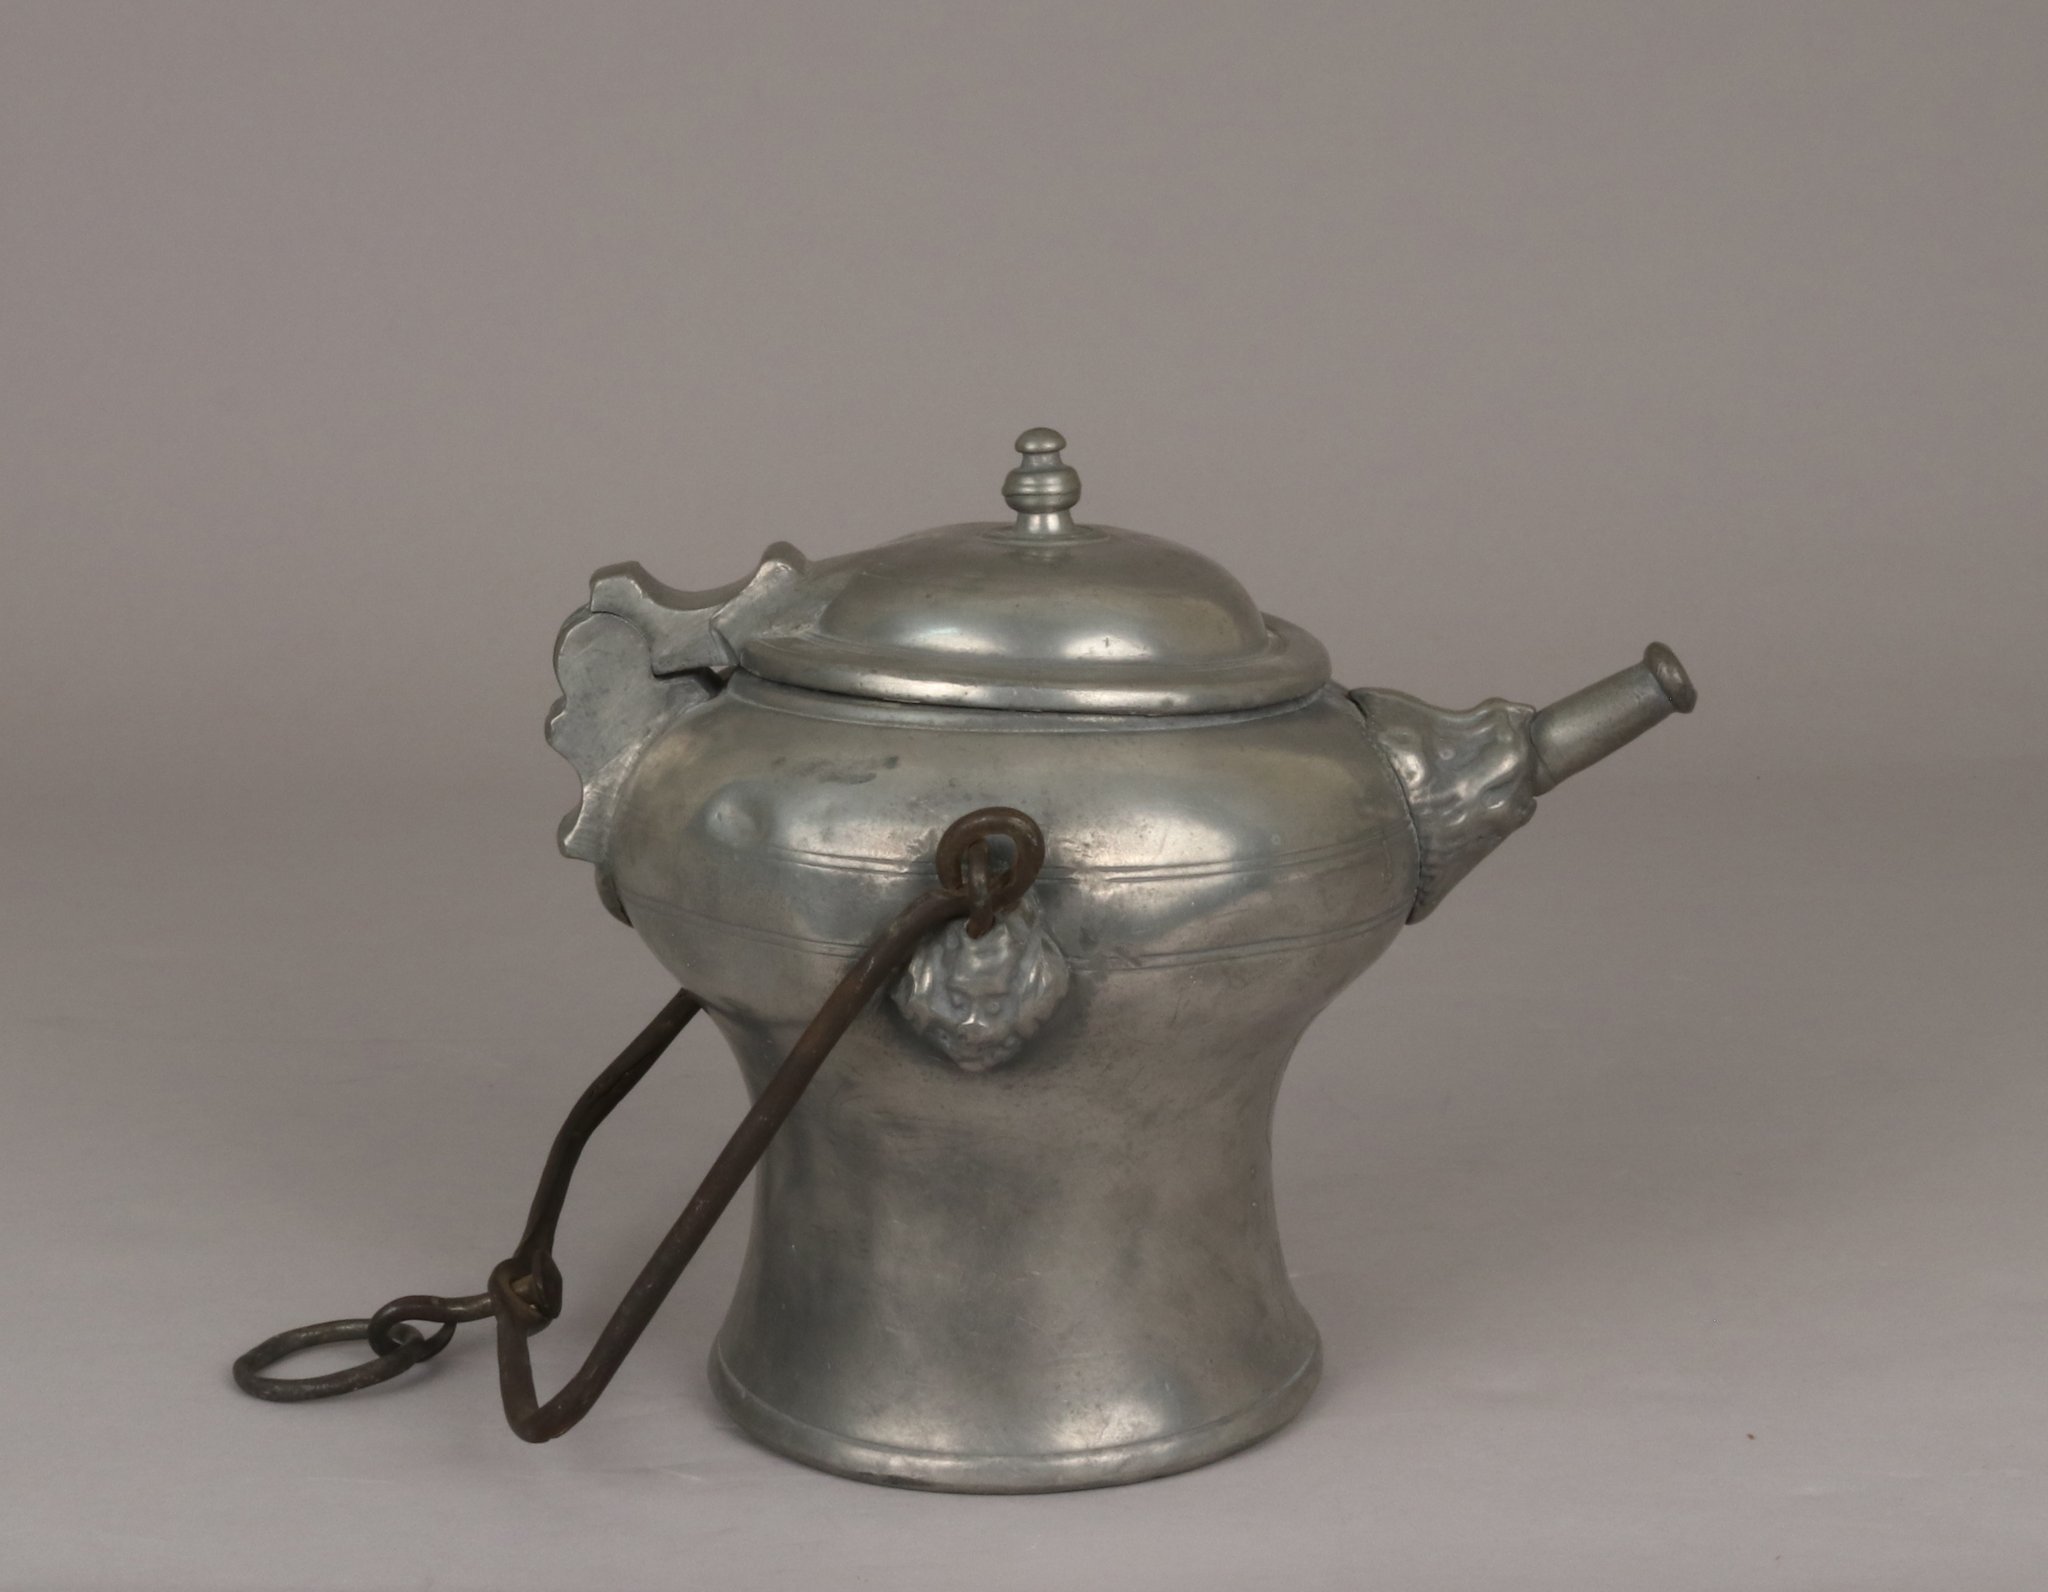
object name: biberon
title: Biberon (sugerli)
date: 1742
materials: pewter